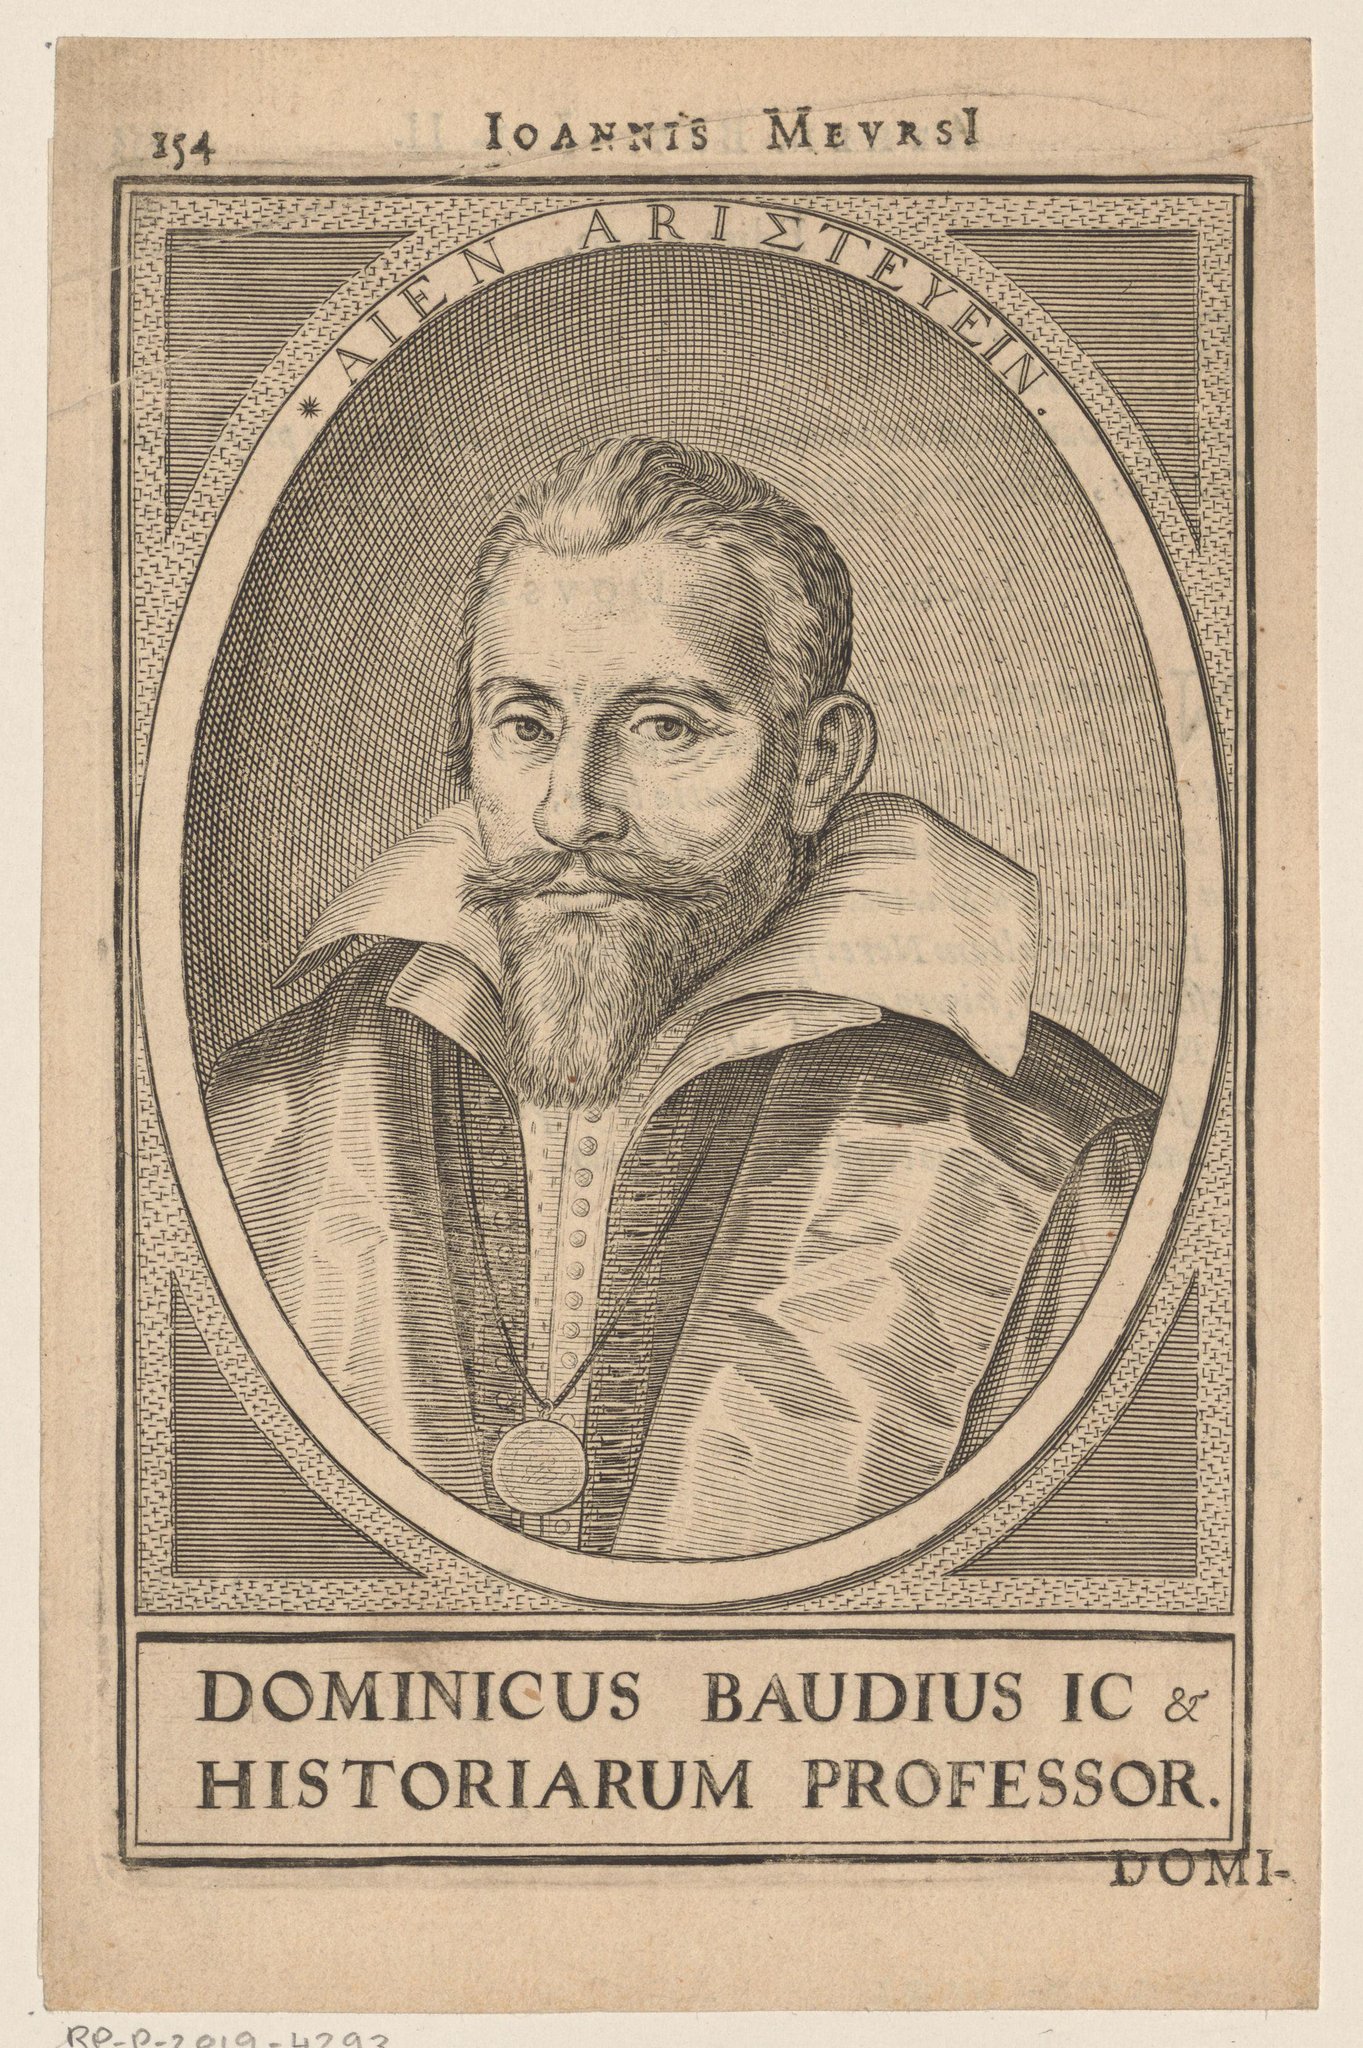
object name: book illustration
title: Portret van Dominicus Baudius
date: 1625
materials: paper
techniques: engraving, letterpress printing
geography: leiden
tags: lille, dominicus baudius, historical persons, writer, poet, author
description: Prent uit: Meurs, Jacob van. Athenae Batavae (...). Leiden: Elzevier en Andries Clouck, 1625, p. 154. Prent voor het eerst, zonder motto, veschenen in: Icones ad vivum delineatae et expressae, virorum clariorum qui praecipue scriptis Academia Lugduno-Batavam illustrarunt. Leiden: Andries Clouck, 1609.